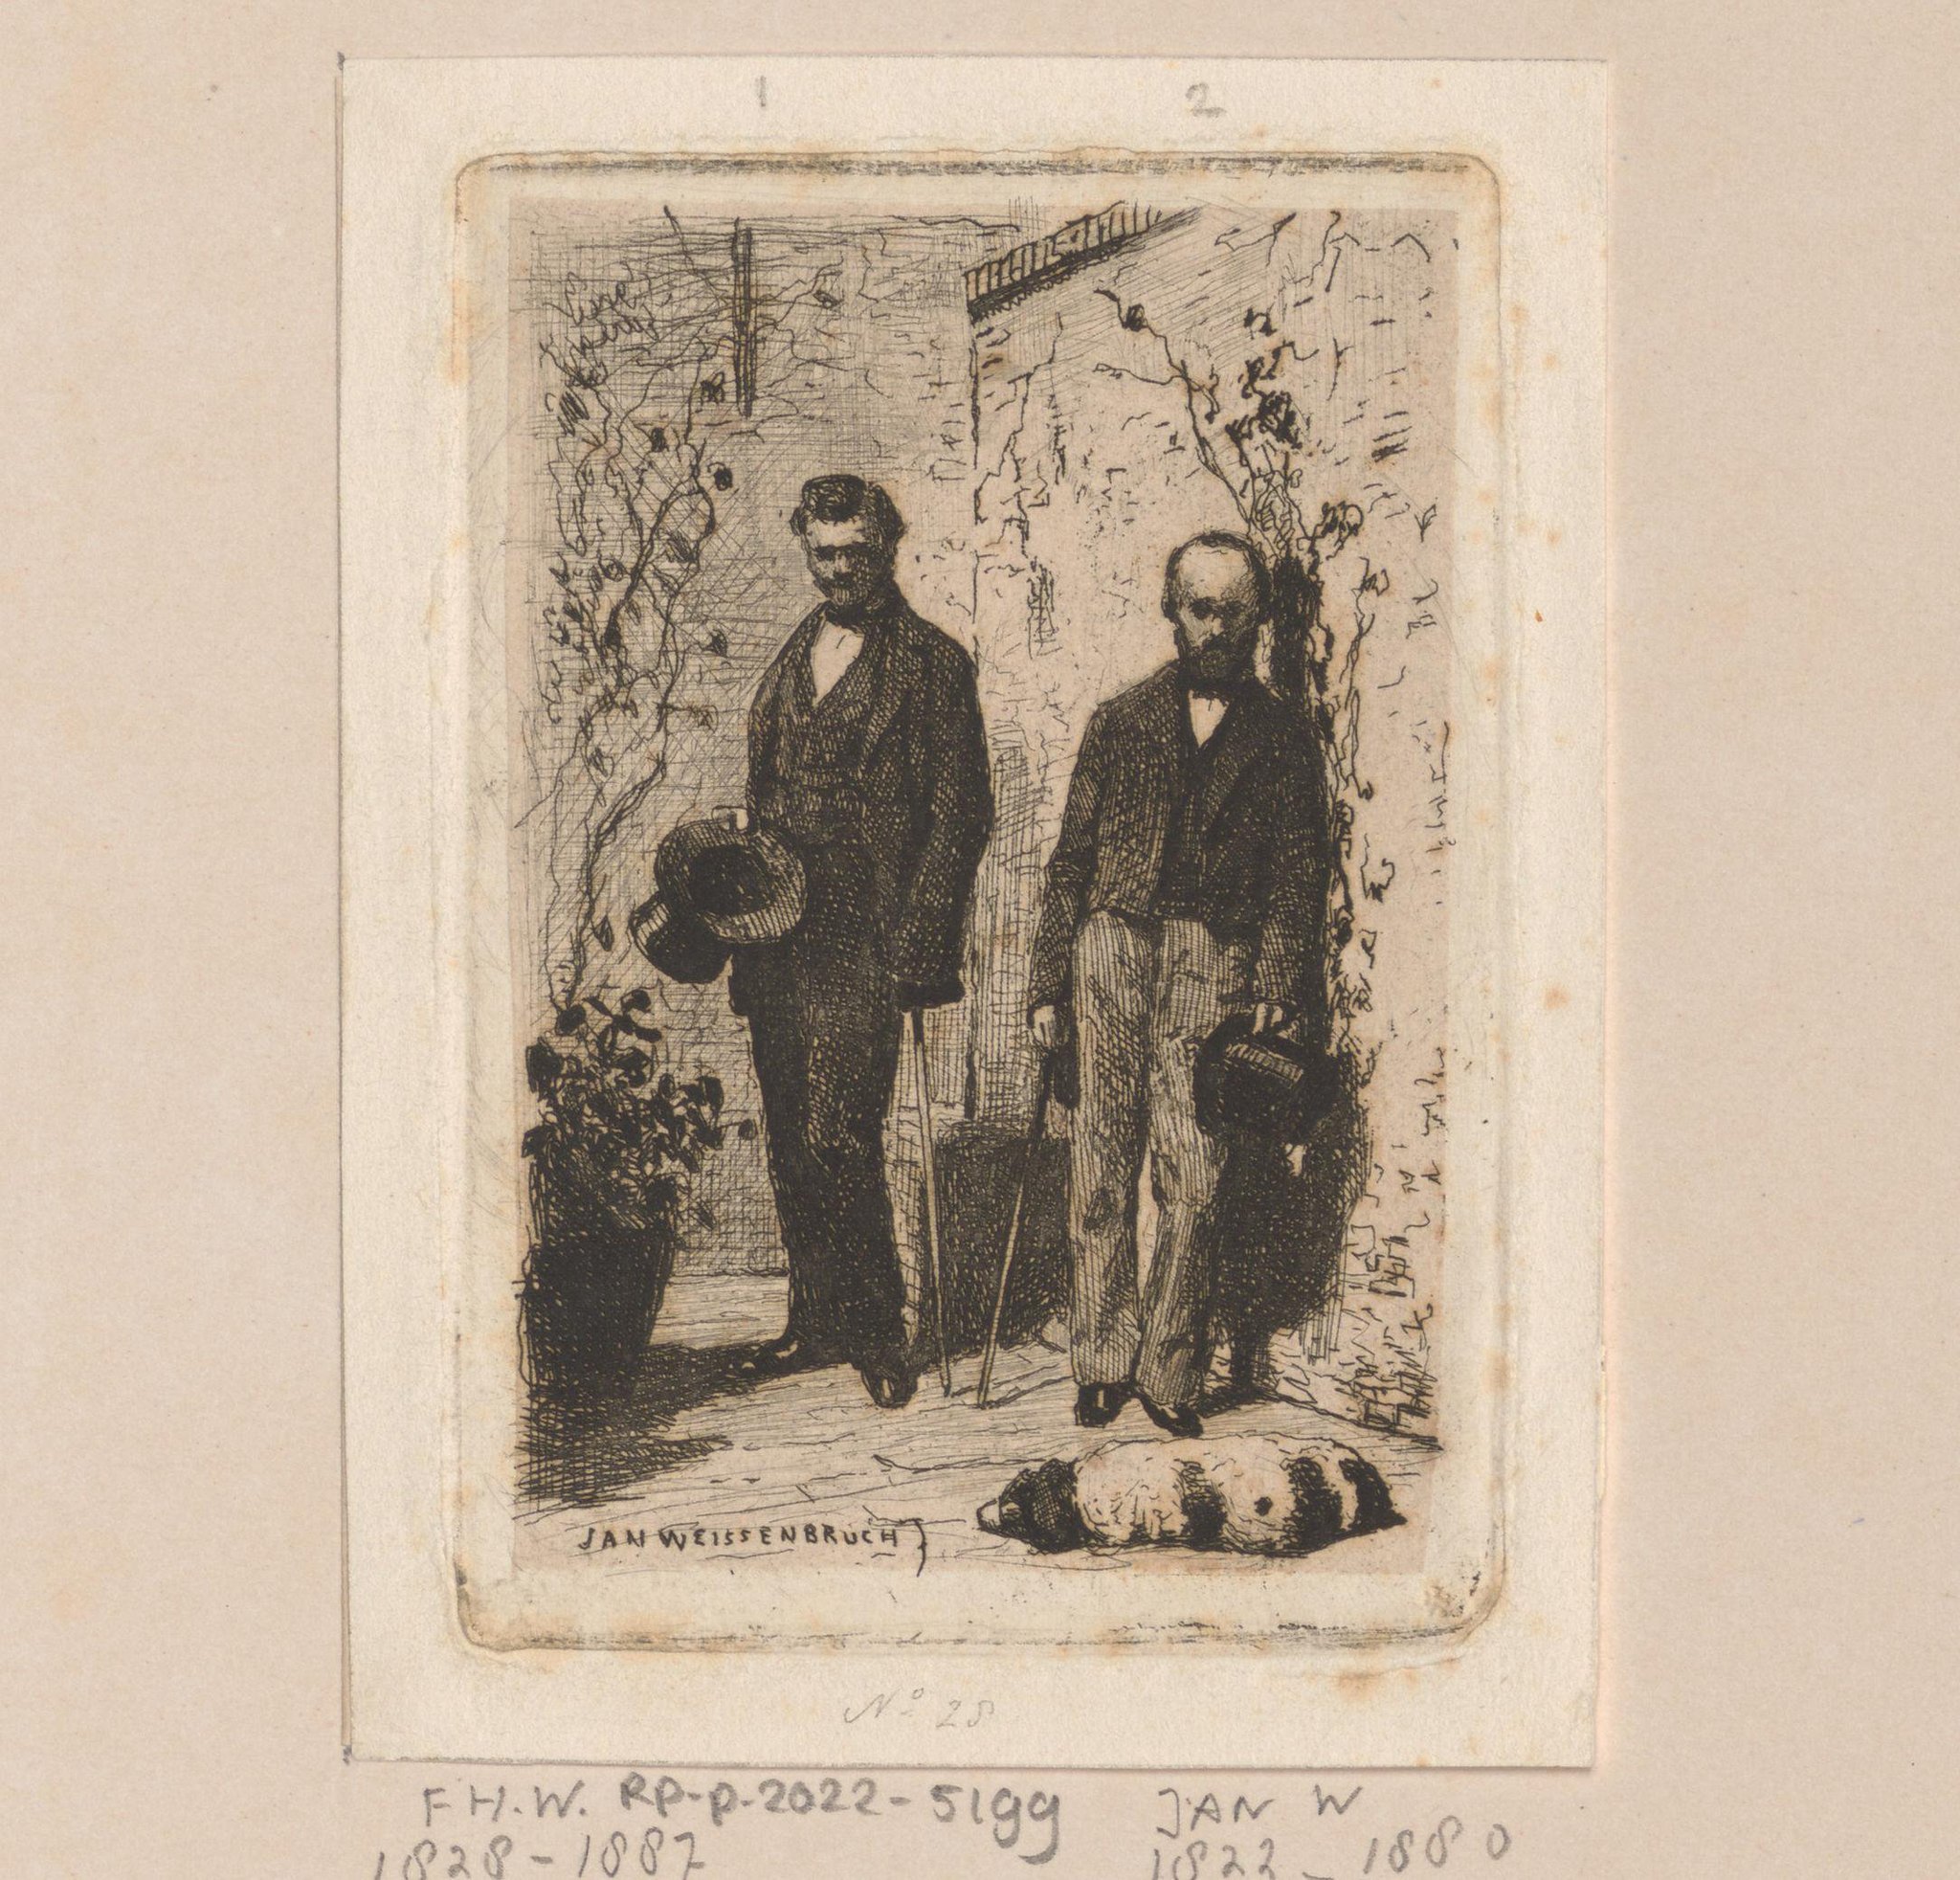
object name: print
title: Zelfportret met Frederik Hendrik Weissenbruch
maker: jan weissenbruch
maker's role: painter, print maker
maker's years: 1822-1880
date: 1843-1880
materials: paper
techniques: etching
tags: the hague, print maker, jan weissenbruch, draughtsman, frederik hendrik weissenbruch, historical persons, portrait, self-portrait of painter, portrait, self-portrait of graphic artist, dog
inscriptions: number: ‘No. 28.’